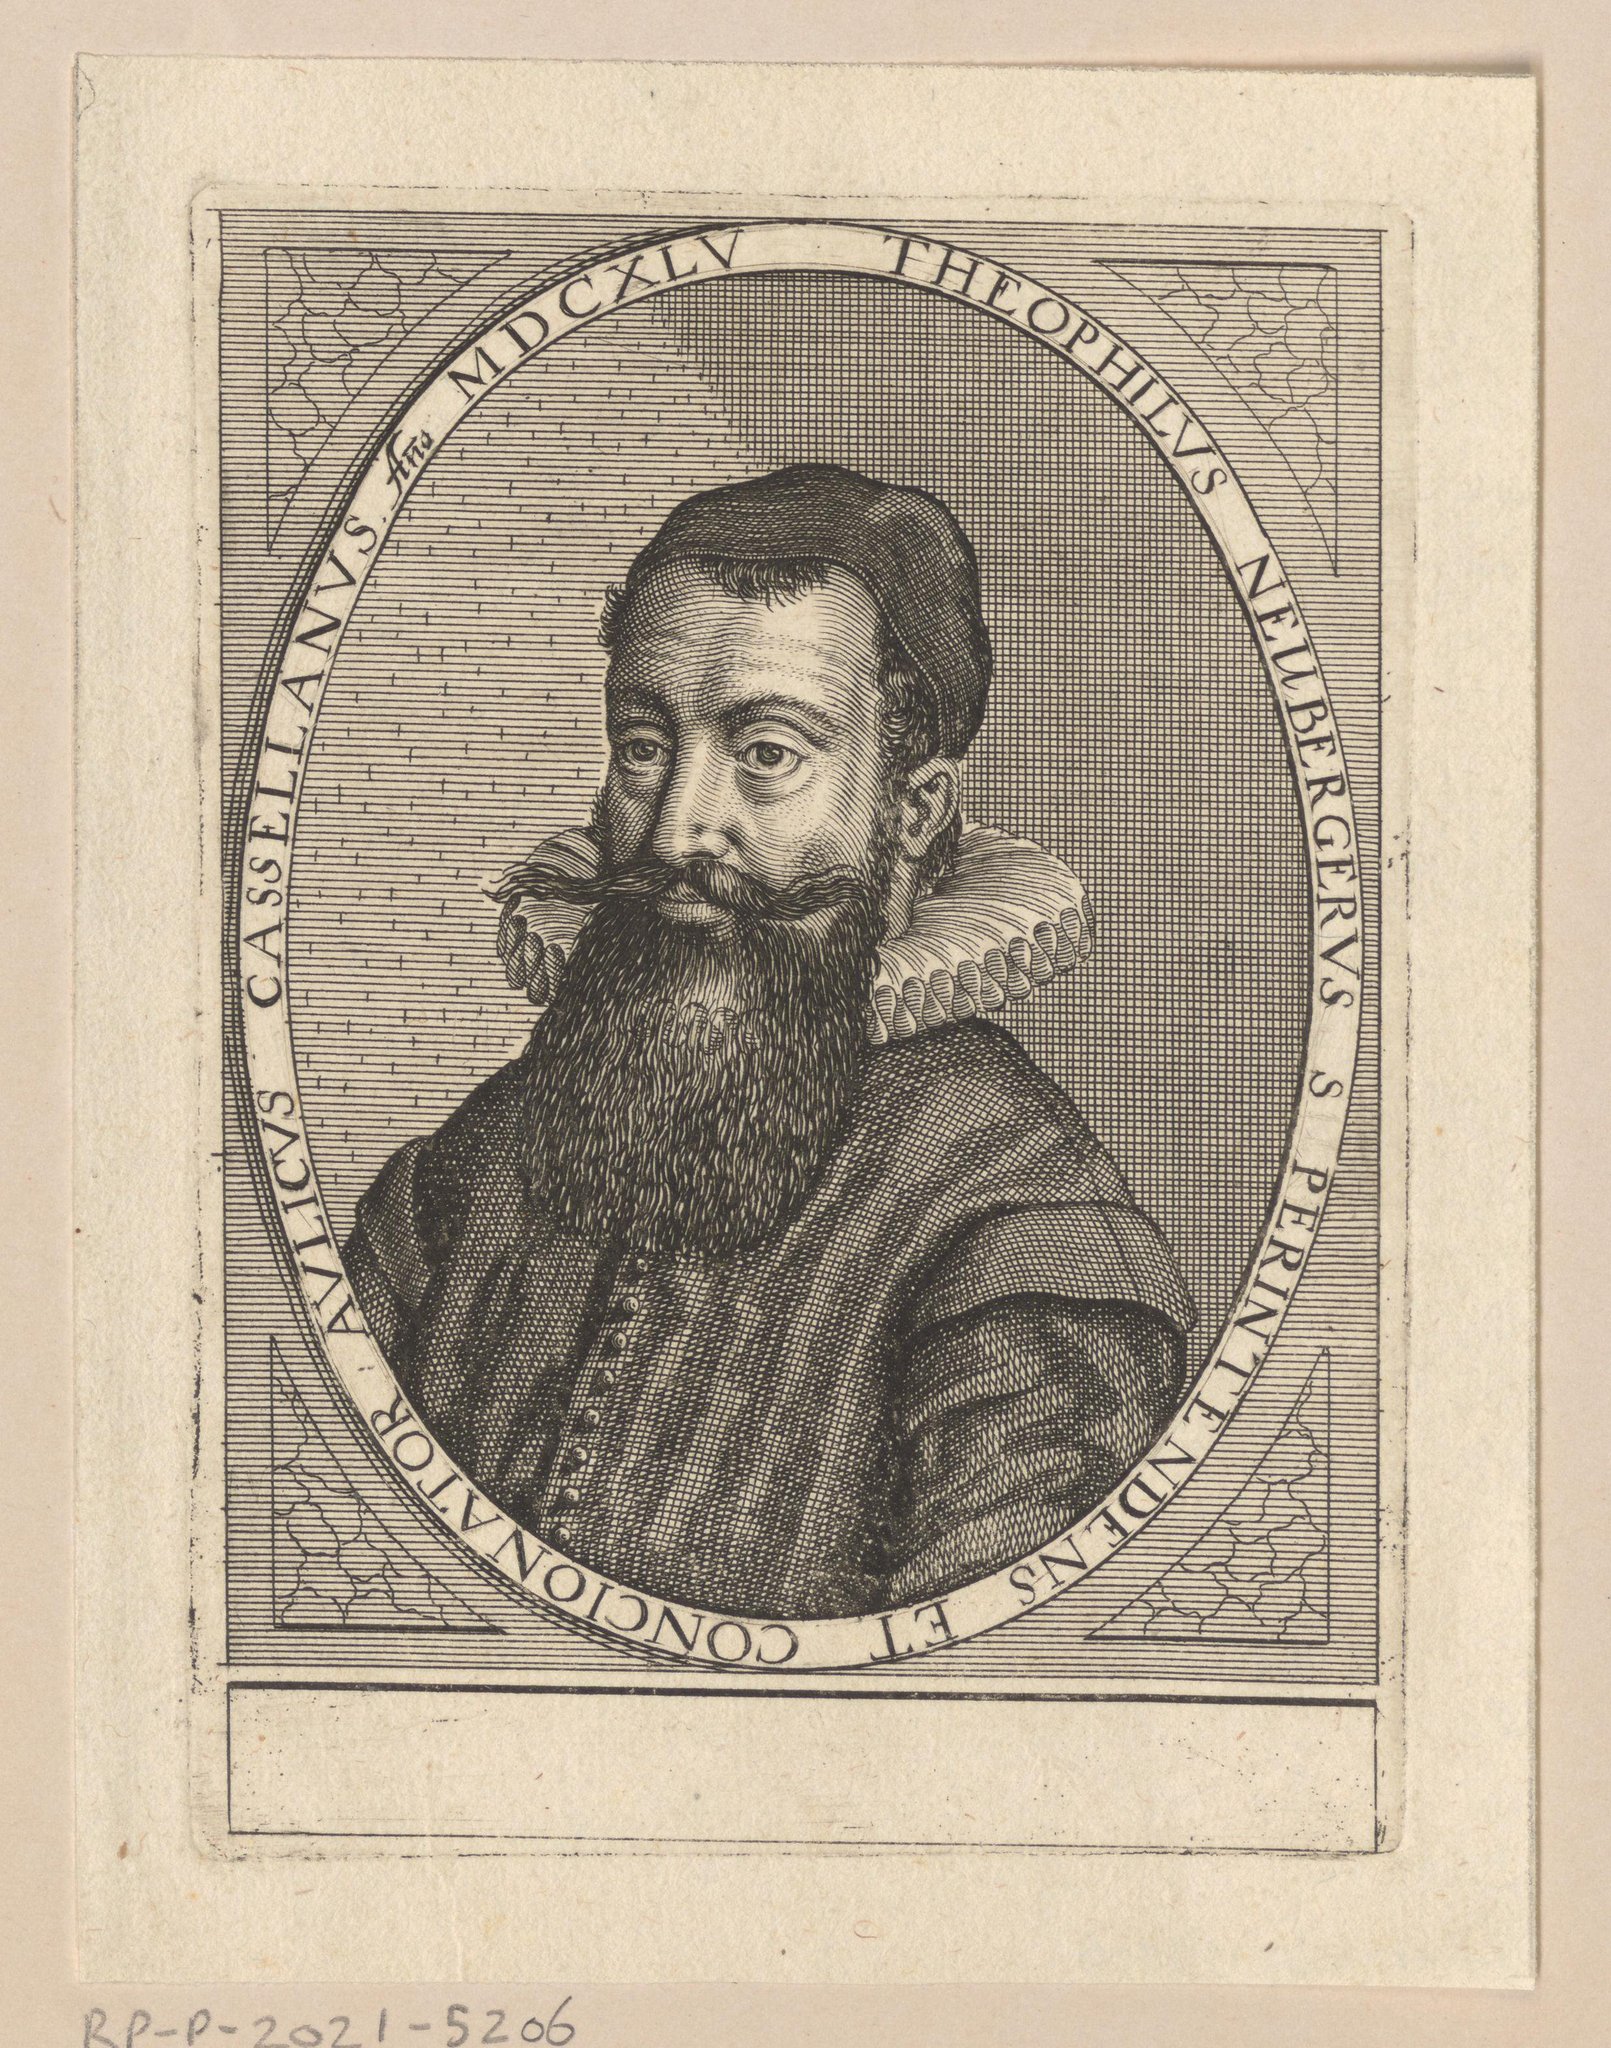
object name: print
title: Portret van Theophilus Neuberger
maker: w.c. heim (prentmaker)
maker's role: print maker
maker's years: 1610-1656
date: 1645-1650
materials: paper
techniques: engraving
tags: theologian, historical persons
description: Latere staat van prent gebruikt in: Boissard, Jean Jacques. Bibliotheca chalcographica (...) VIII pars. Frankfurt am Main: Johannes Ammon, 1650, dl 6.